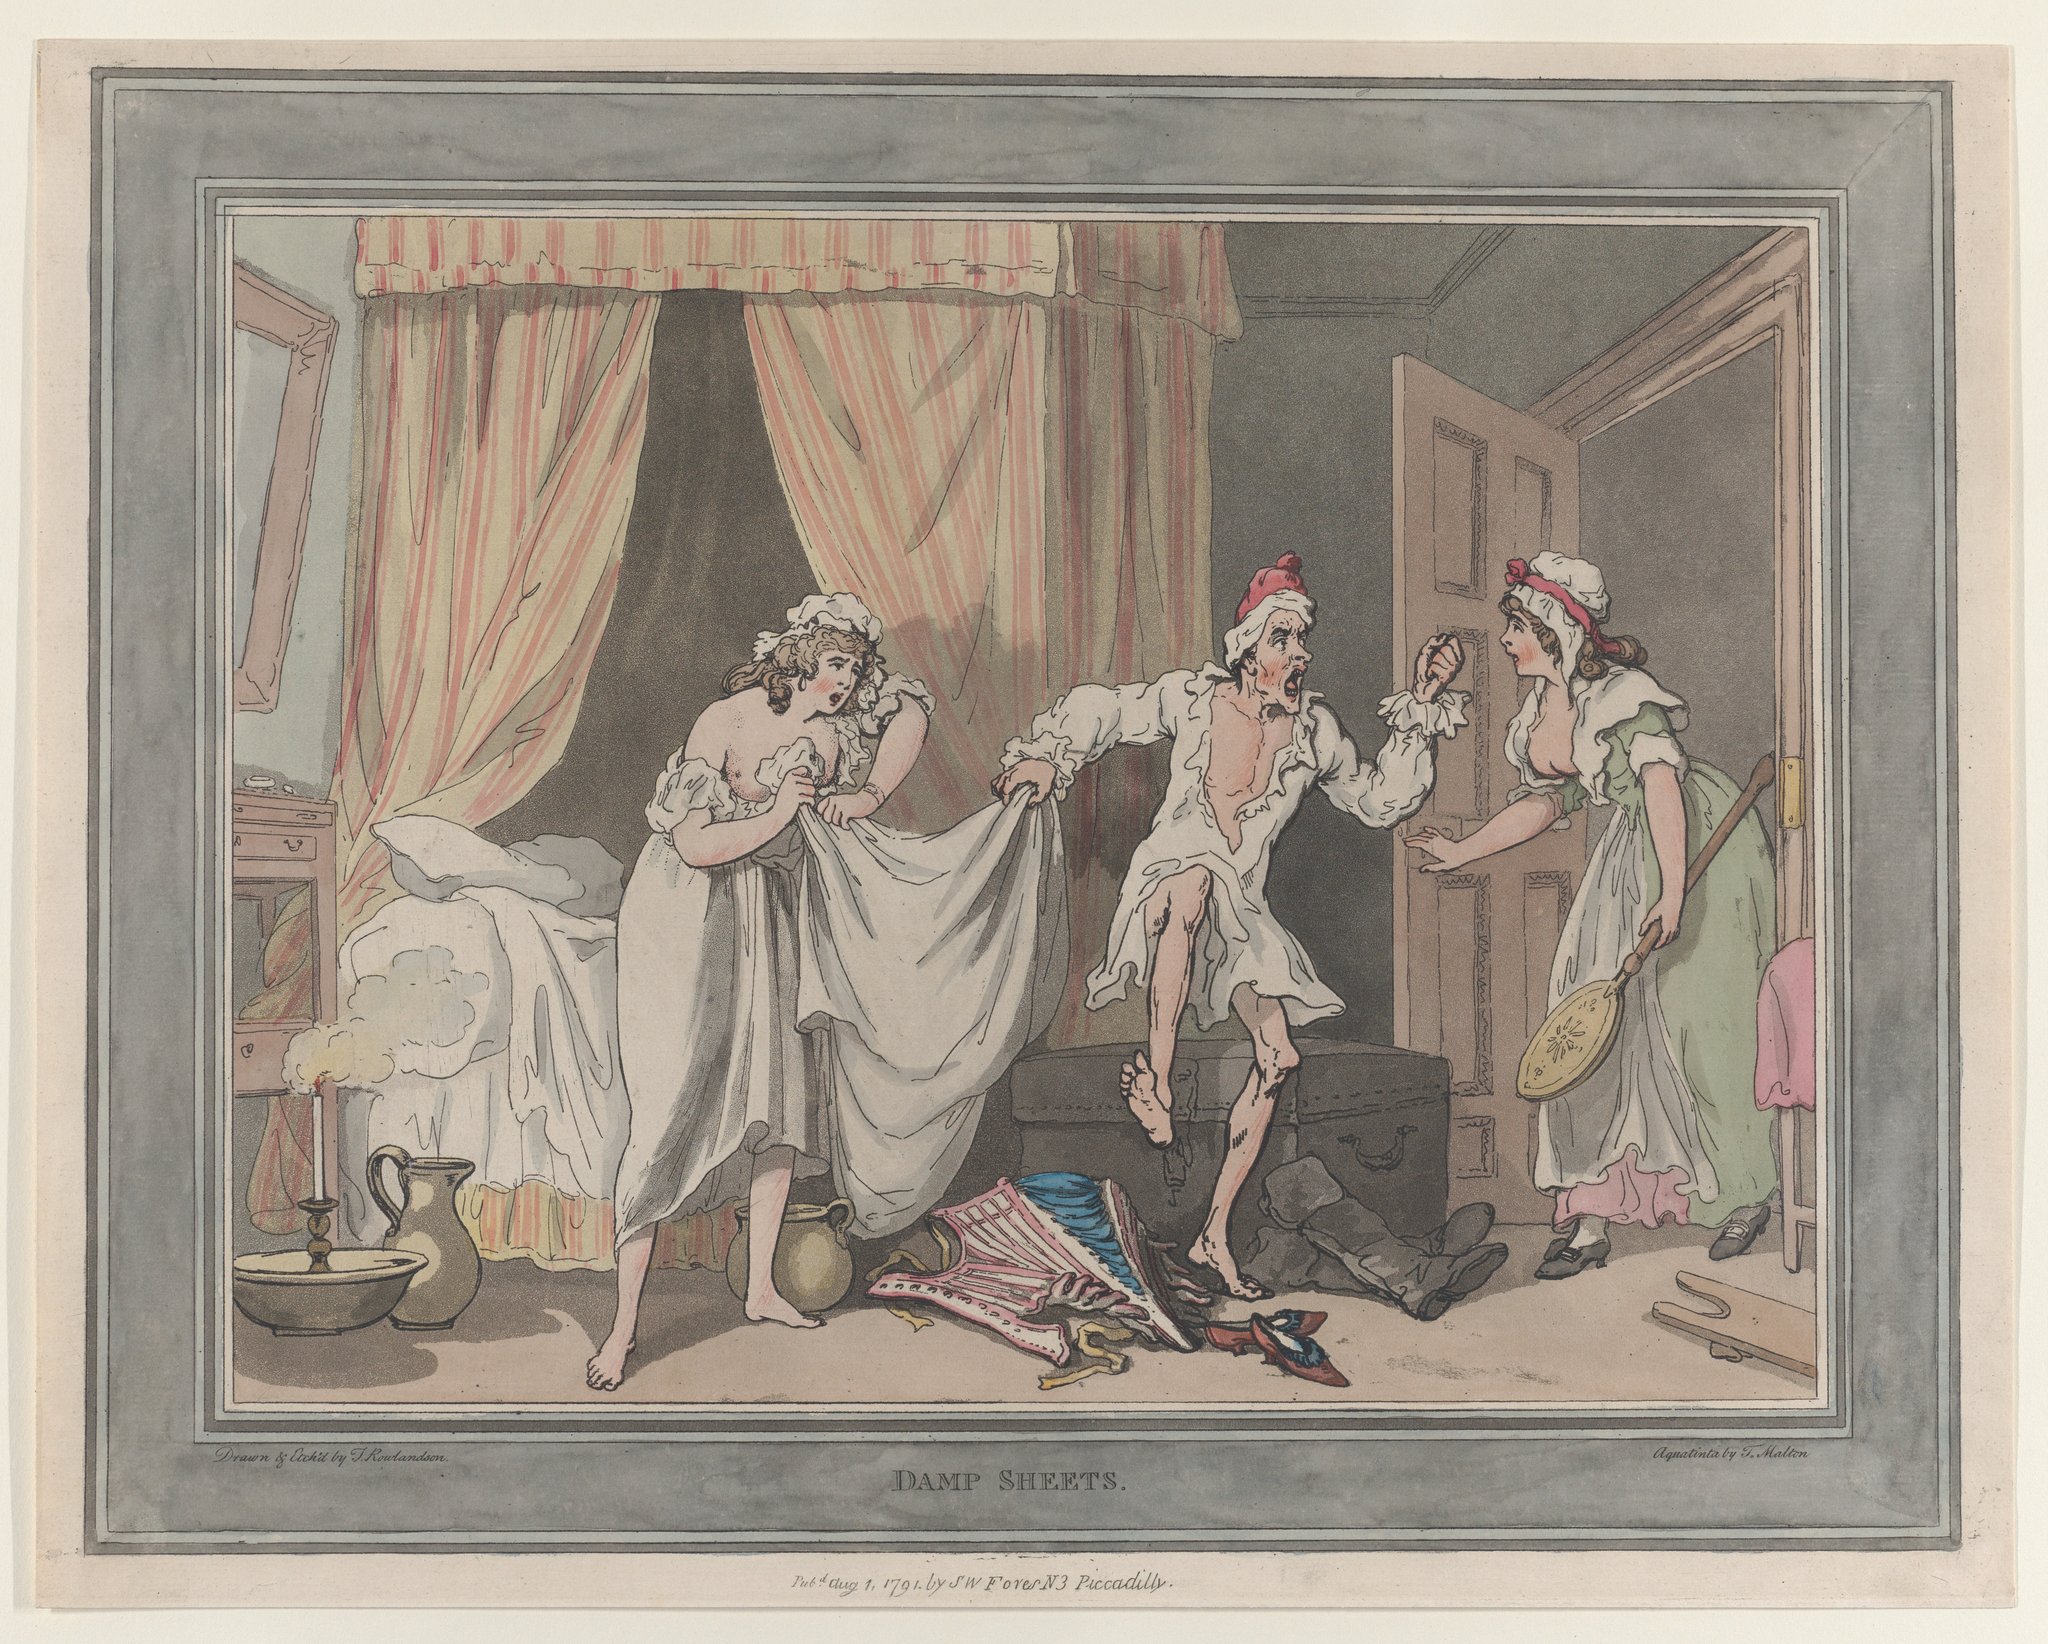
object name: print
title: Damp Sheets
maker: thomas rowlandson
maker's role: artist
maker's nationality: british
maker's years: 1757-1827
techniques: aquatint, etching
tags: satire,bedrooms,men,women